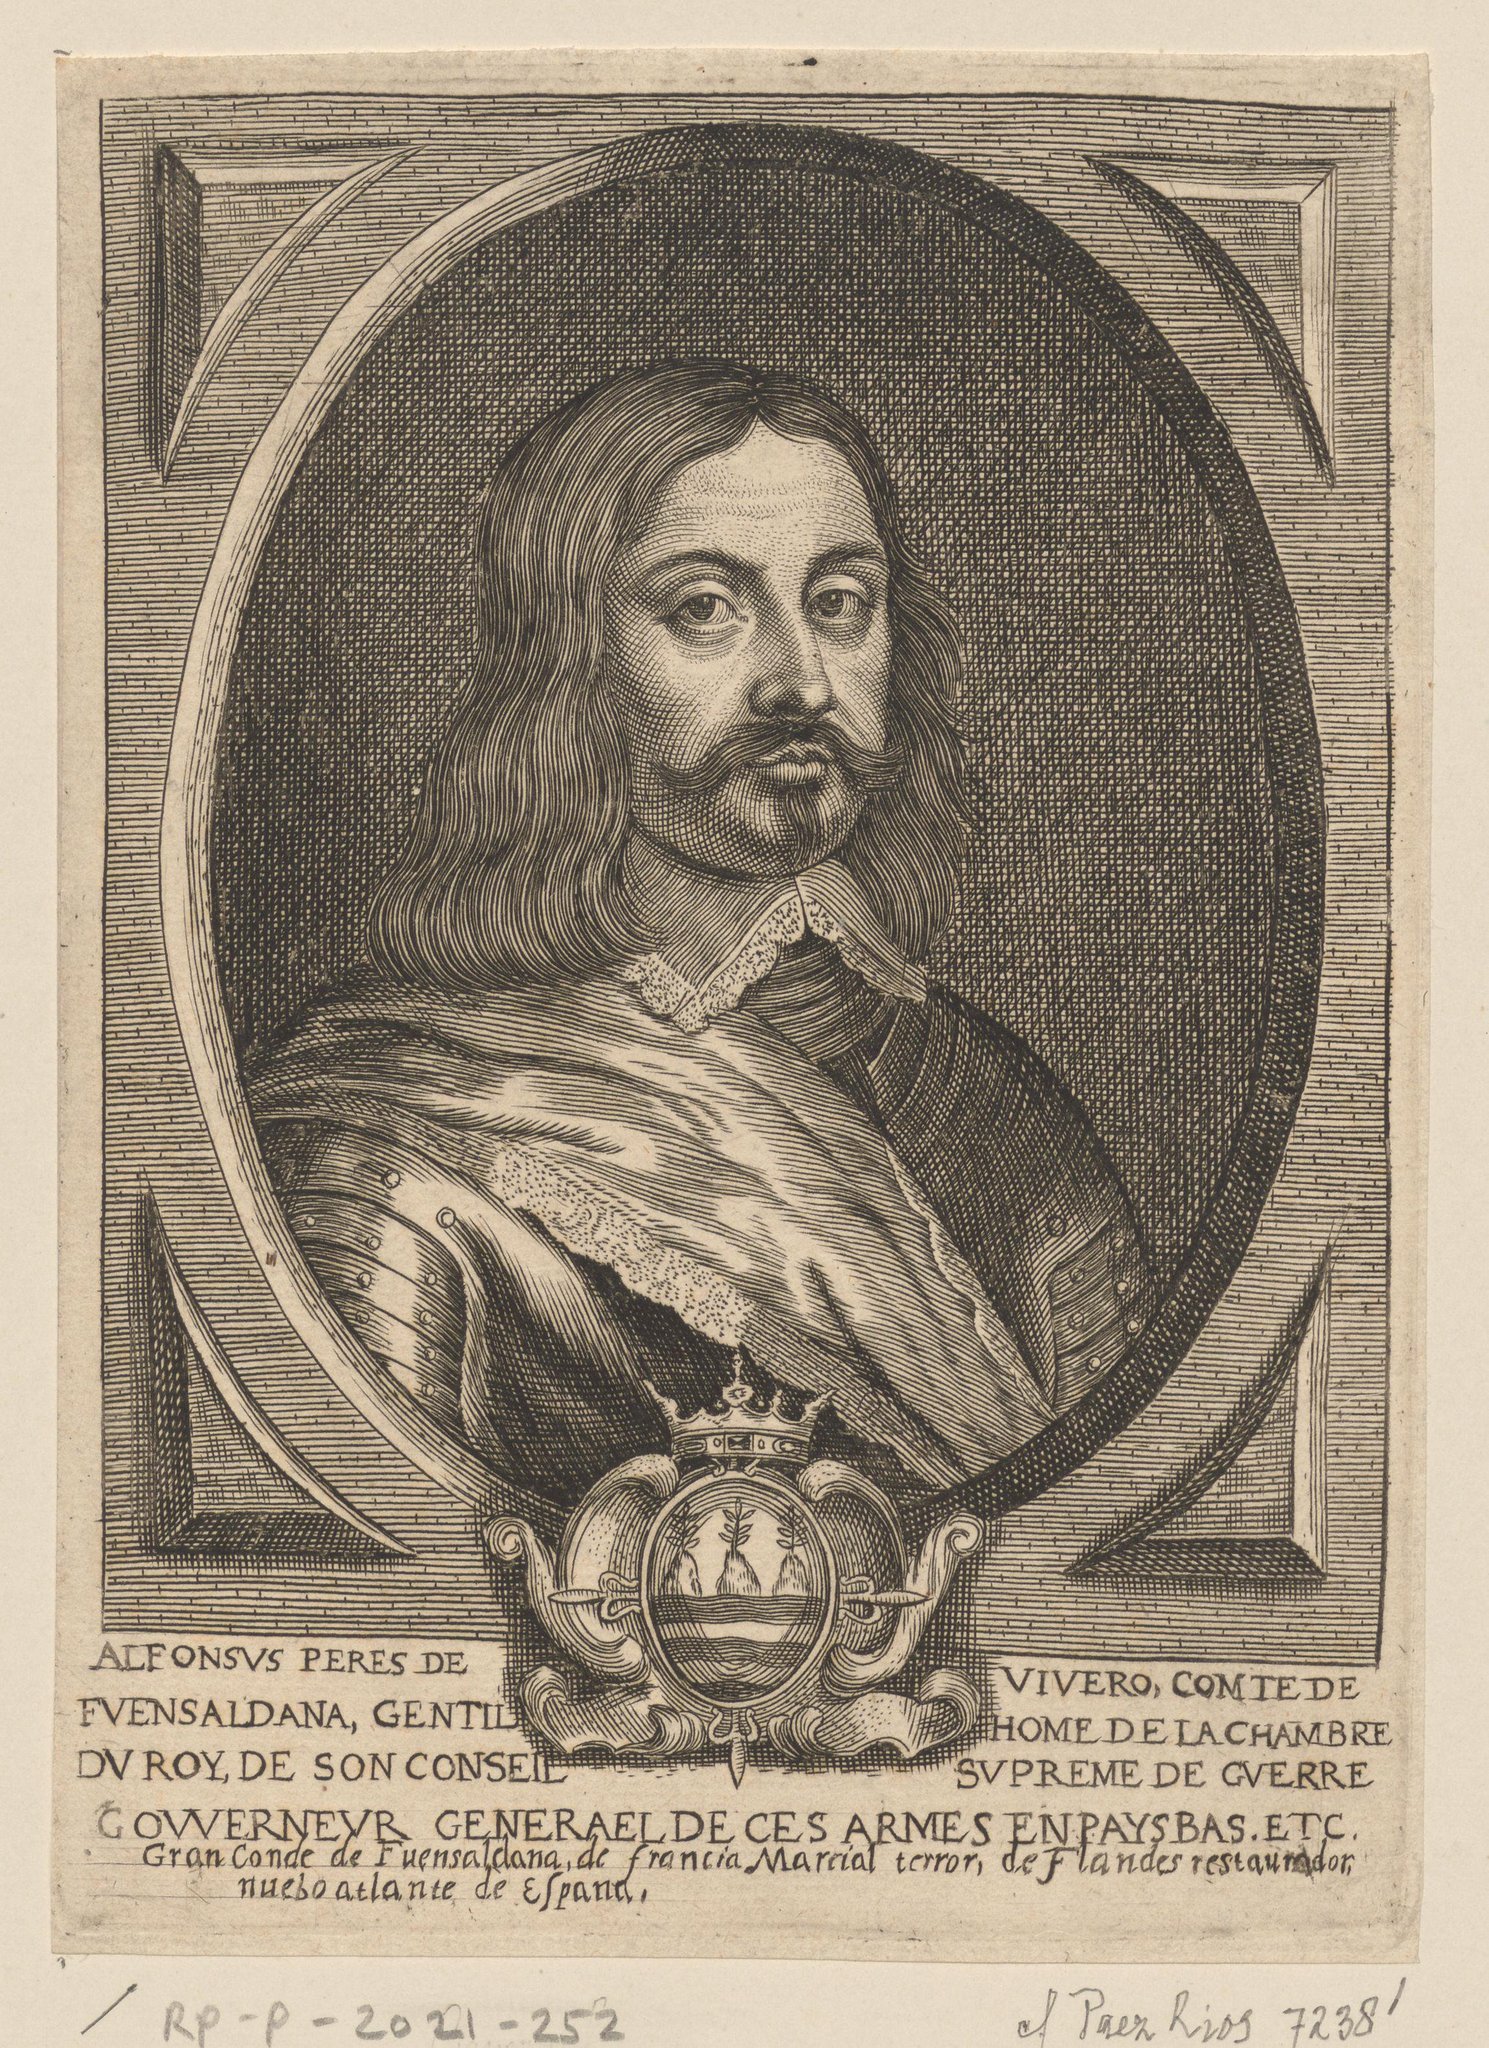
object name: print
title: Portret van Alfonso Pérez de Vivero, graaf van Fuensaldaña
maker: Anonymous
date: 1640-1700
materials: paper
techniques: engraving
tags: alonso pérez de vivero y menchaca (graaf van fuensaldaña), historical persons, armorial bearing, heraldry